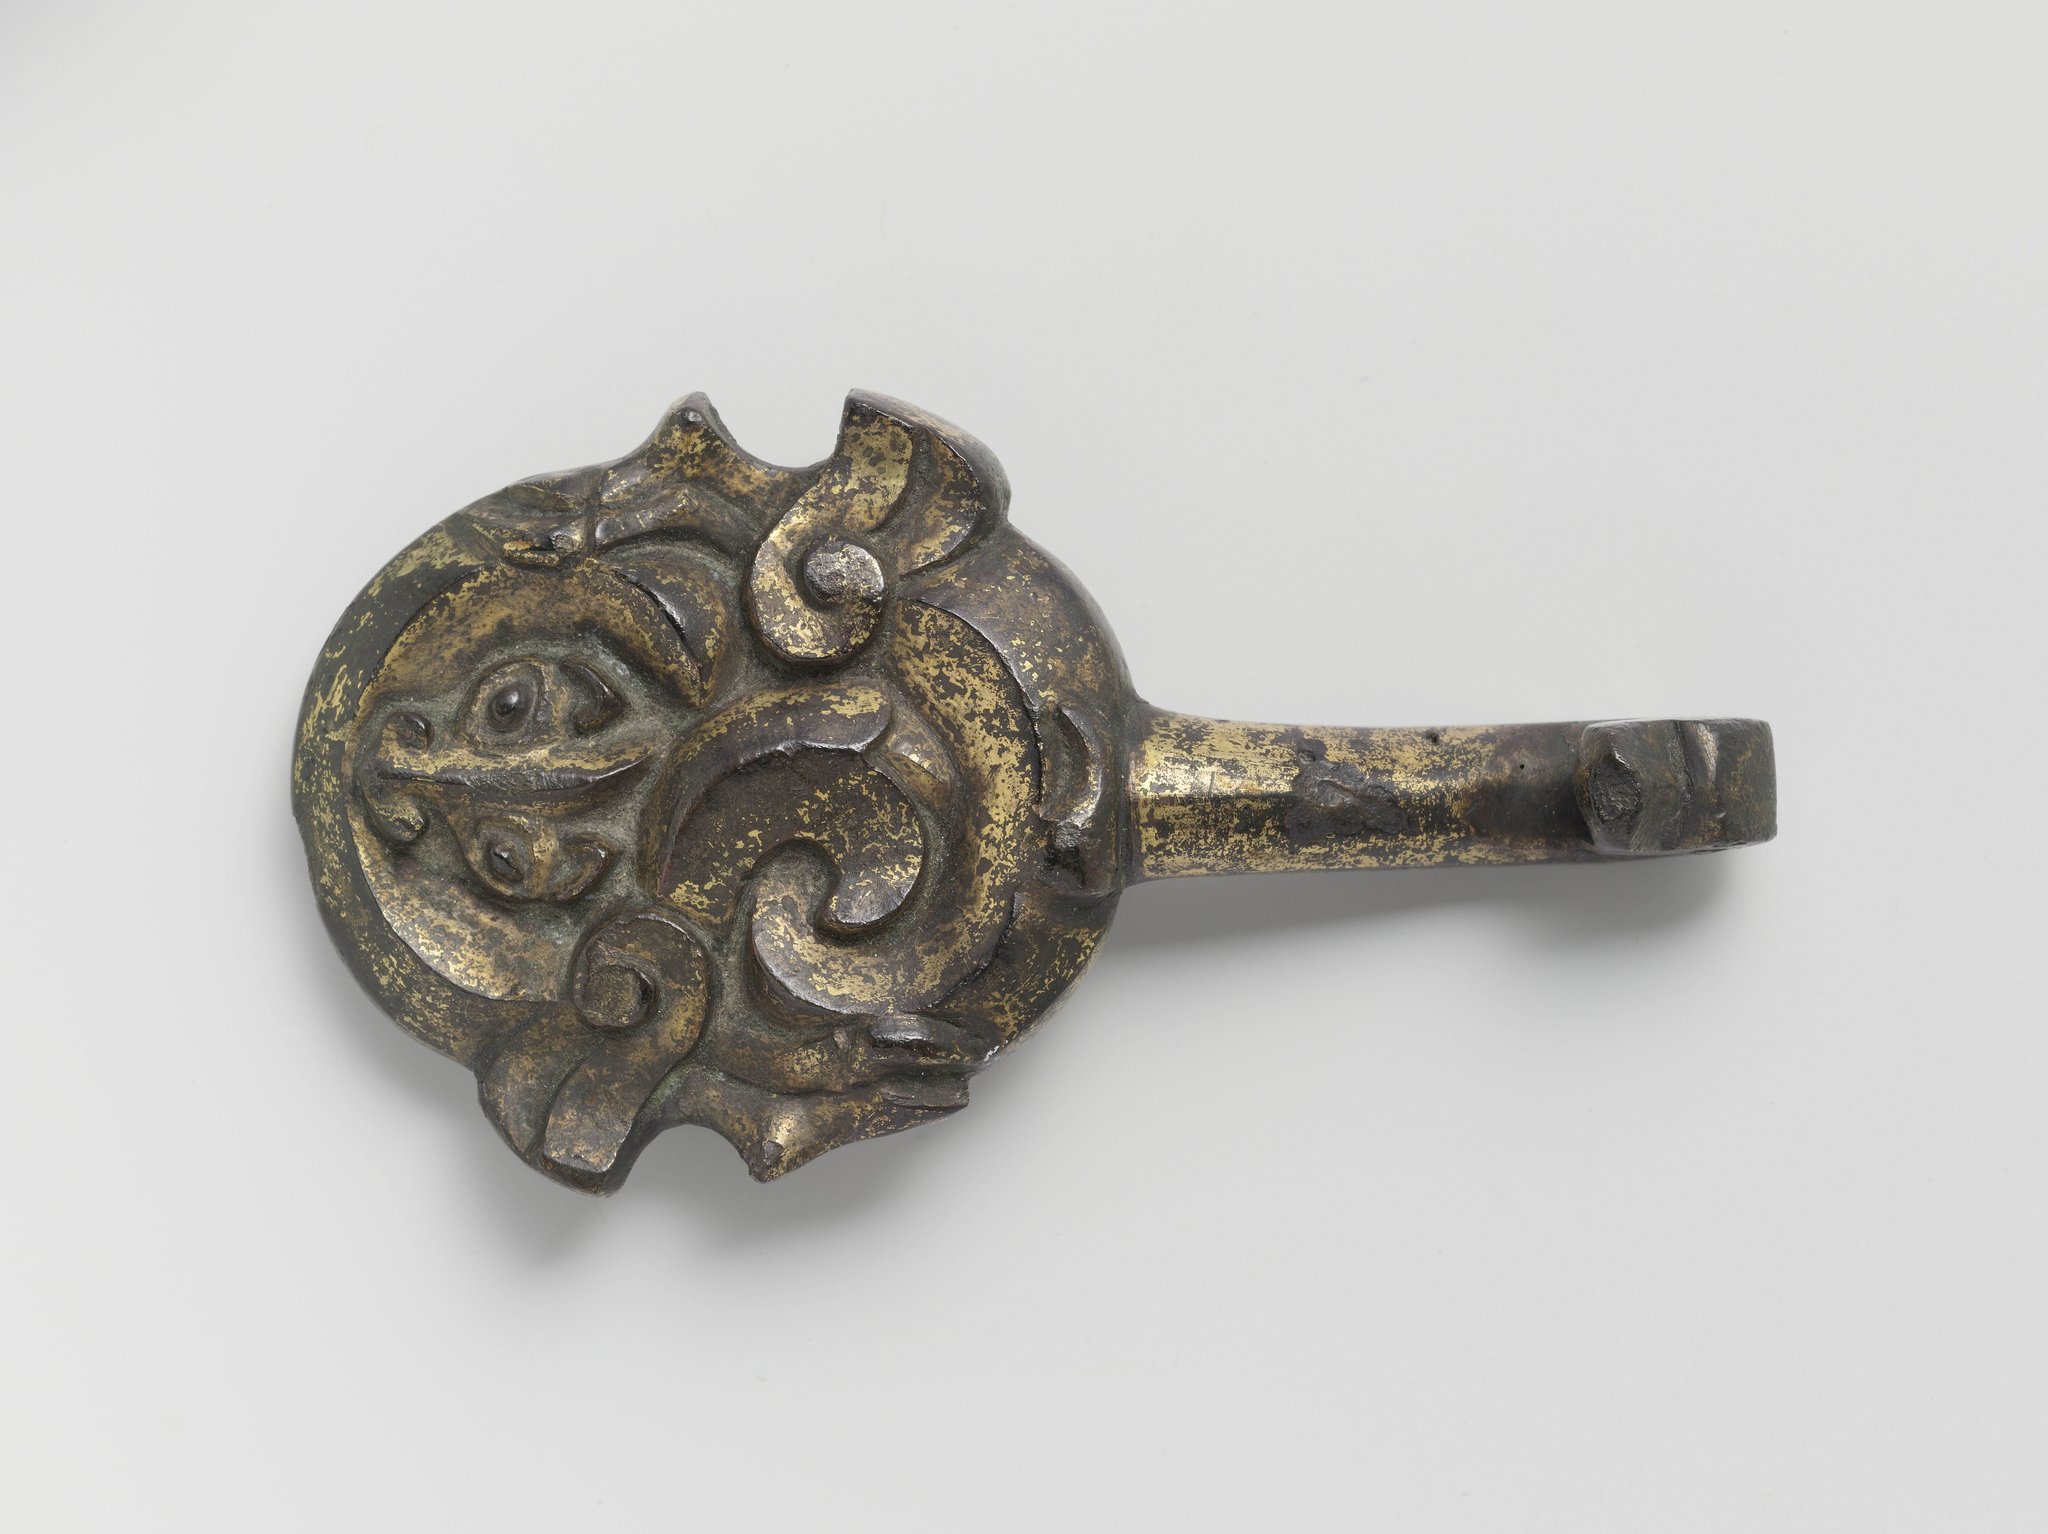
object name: gordelhaak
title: Gordelhaak van verguld brons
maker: Anonymous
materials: bronze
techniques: gilding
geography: china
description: Pair of belt buckles in the form of stylized animals. Given by Mr and Mrs Van Beek.